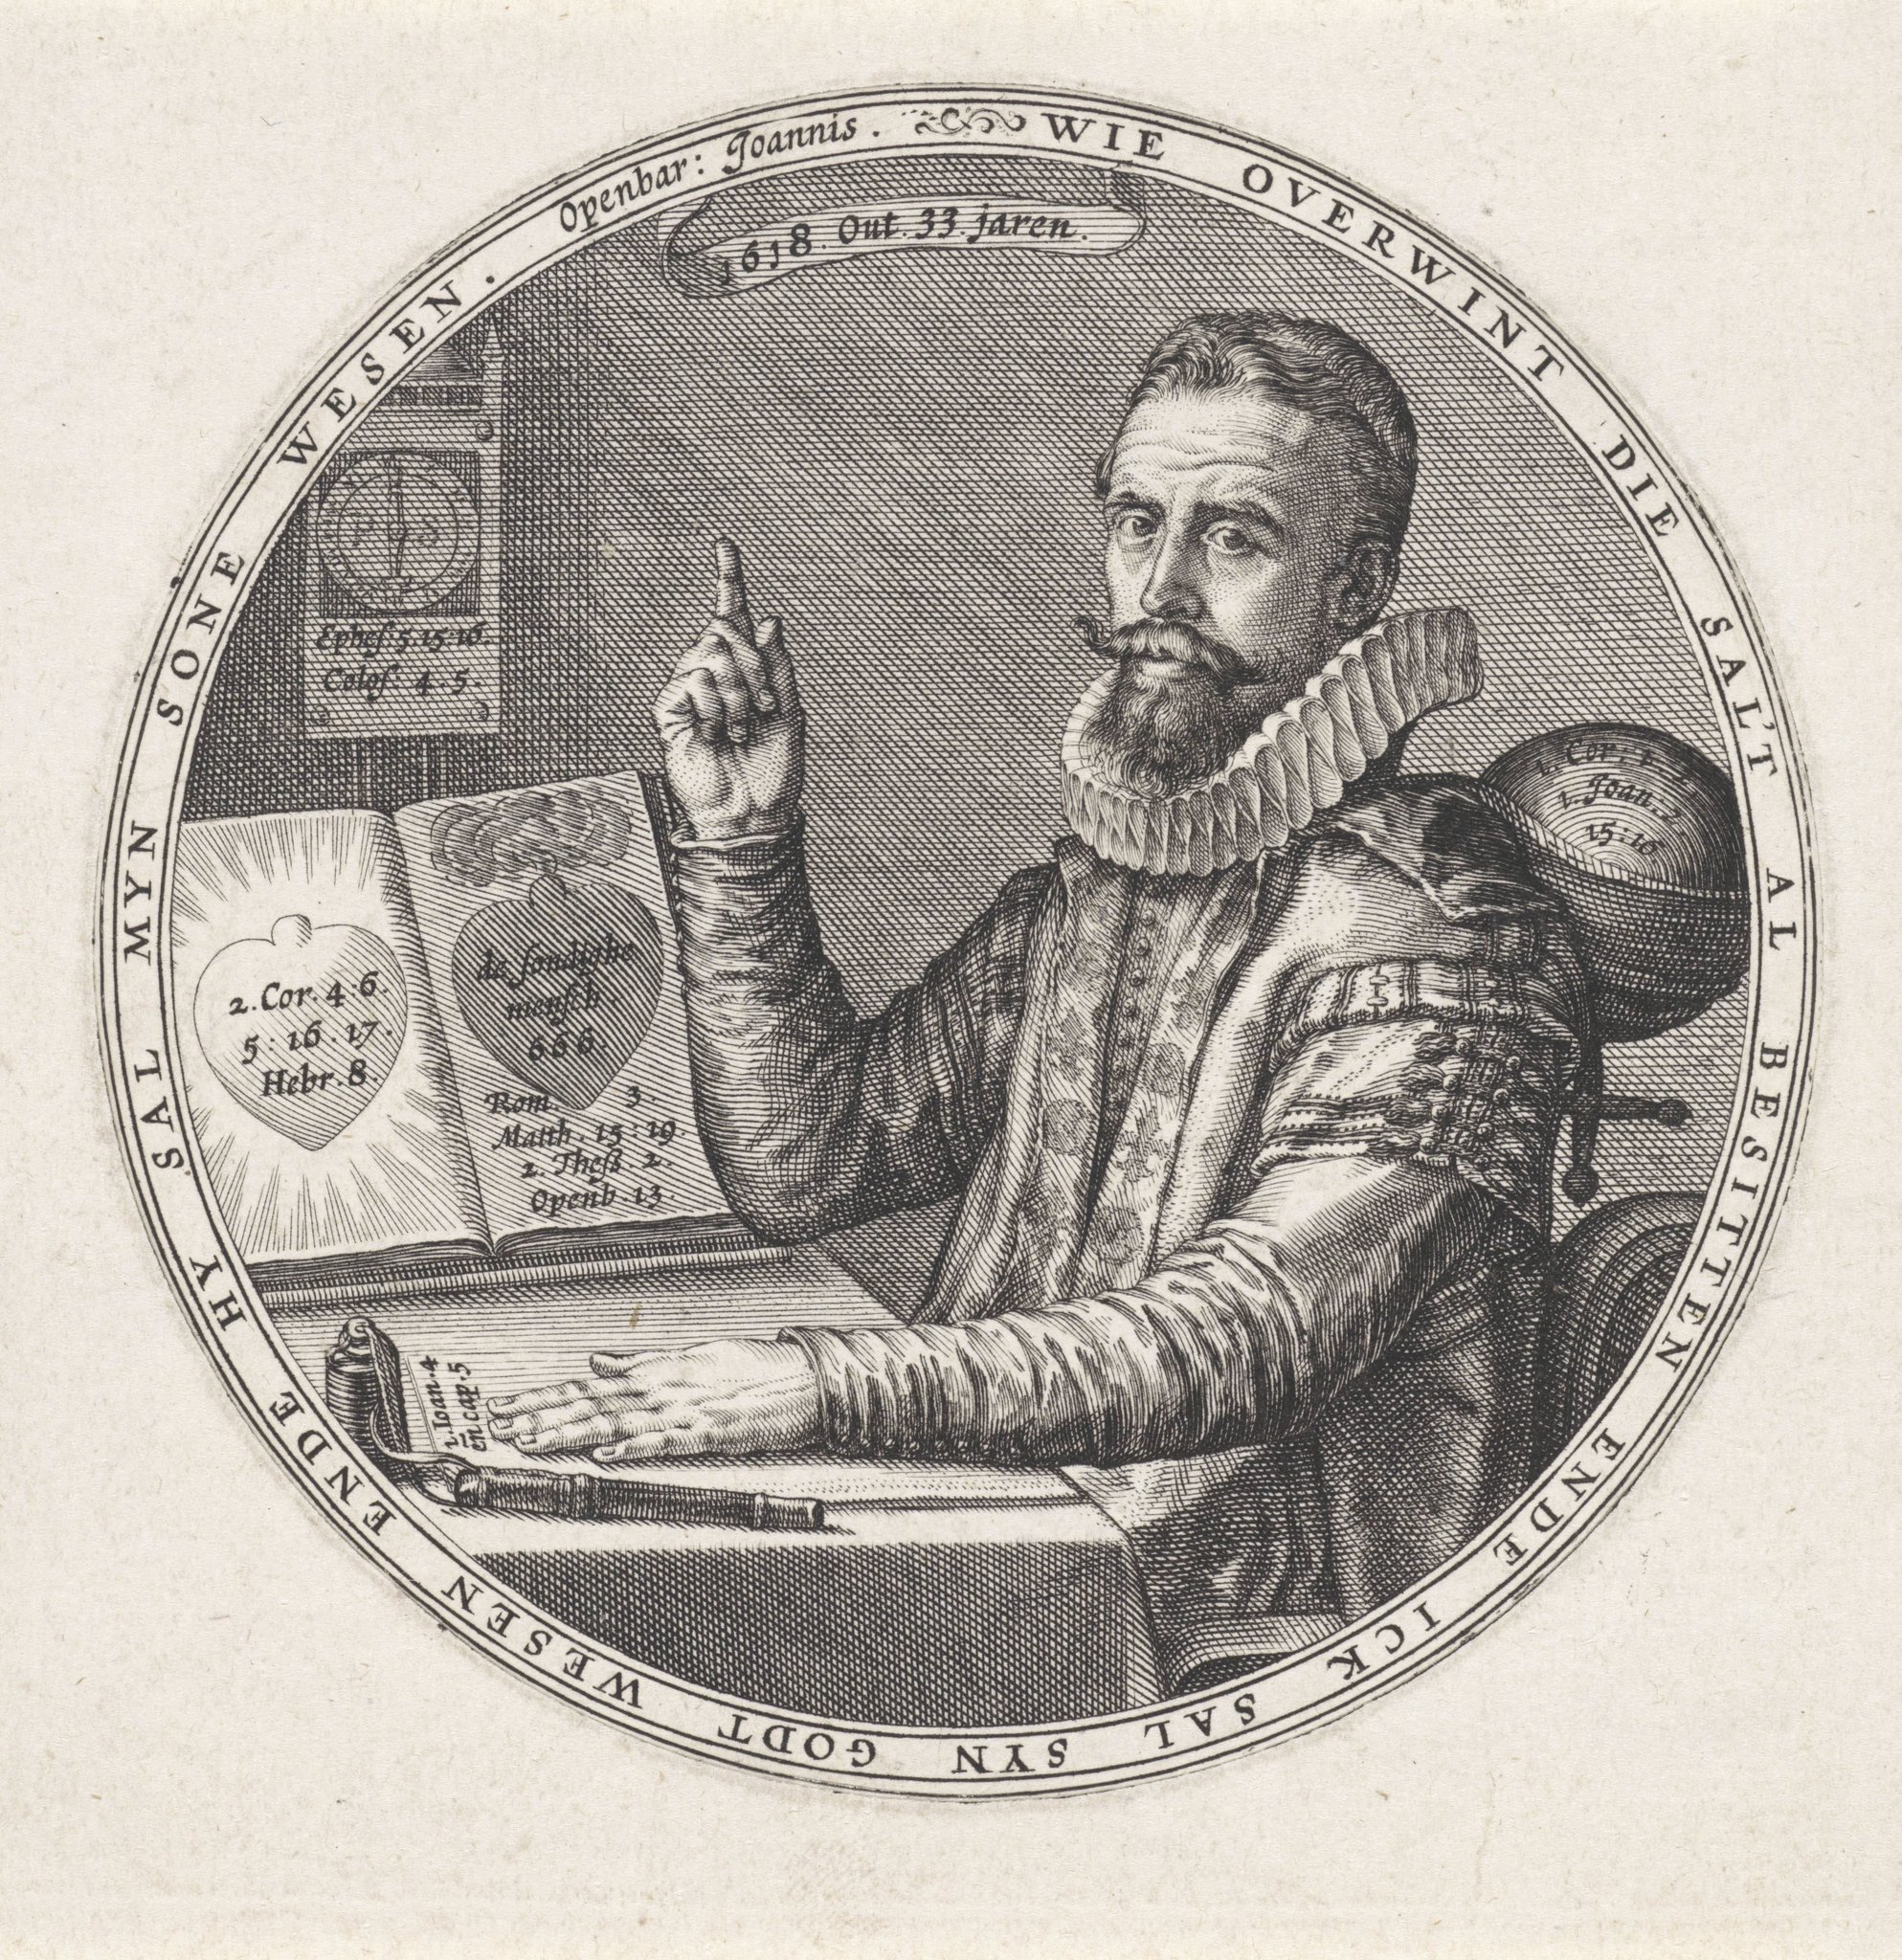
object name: print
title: Portret van Nicolaas Grevinkhoven of van Vincent Anthonissoon van Drielenburgh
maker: pieter serwouters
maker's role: draughtsman, print maker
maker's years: 1586-1657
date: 1618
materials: paper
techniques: engraving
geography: amsterdam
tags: utrecht, book - mm - book open, clock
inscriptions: collector's mark: Lugt 2228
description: Portret van de Remonstrantse predikant Nicolaas Grevinkhoven of van de jurist en Contra-remonstrantse geestdrijver Vincent Anthonissoon van Drielenburgh op 33-jarige leeftijd. Hij zit aan een tafel met zijn hand op een met een verwijzing naar een Bijbelvers beschreven vel papier. Op tafel een open geslagen boek, met een verwijzing naar verschillende Bijbelteksten, aan de muur een klok, eveneens met Bijbelverwijzingen. In de ronde randomlijsting een Bijbeltekst.